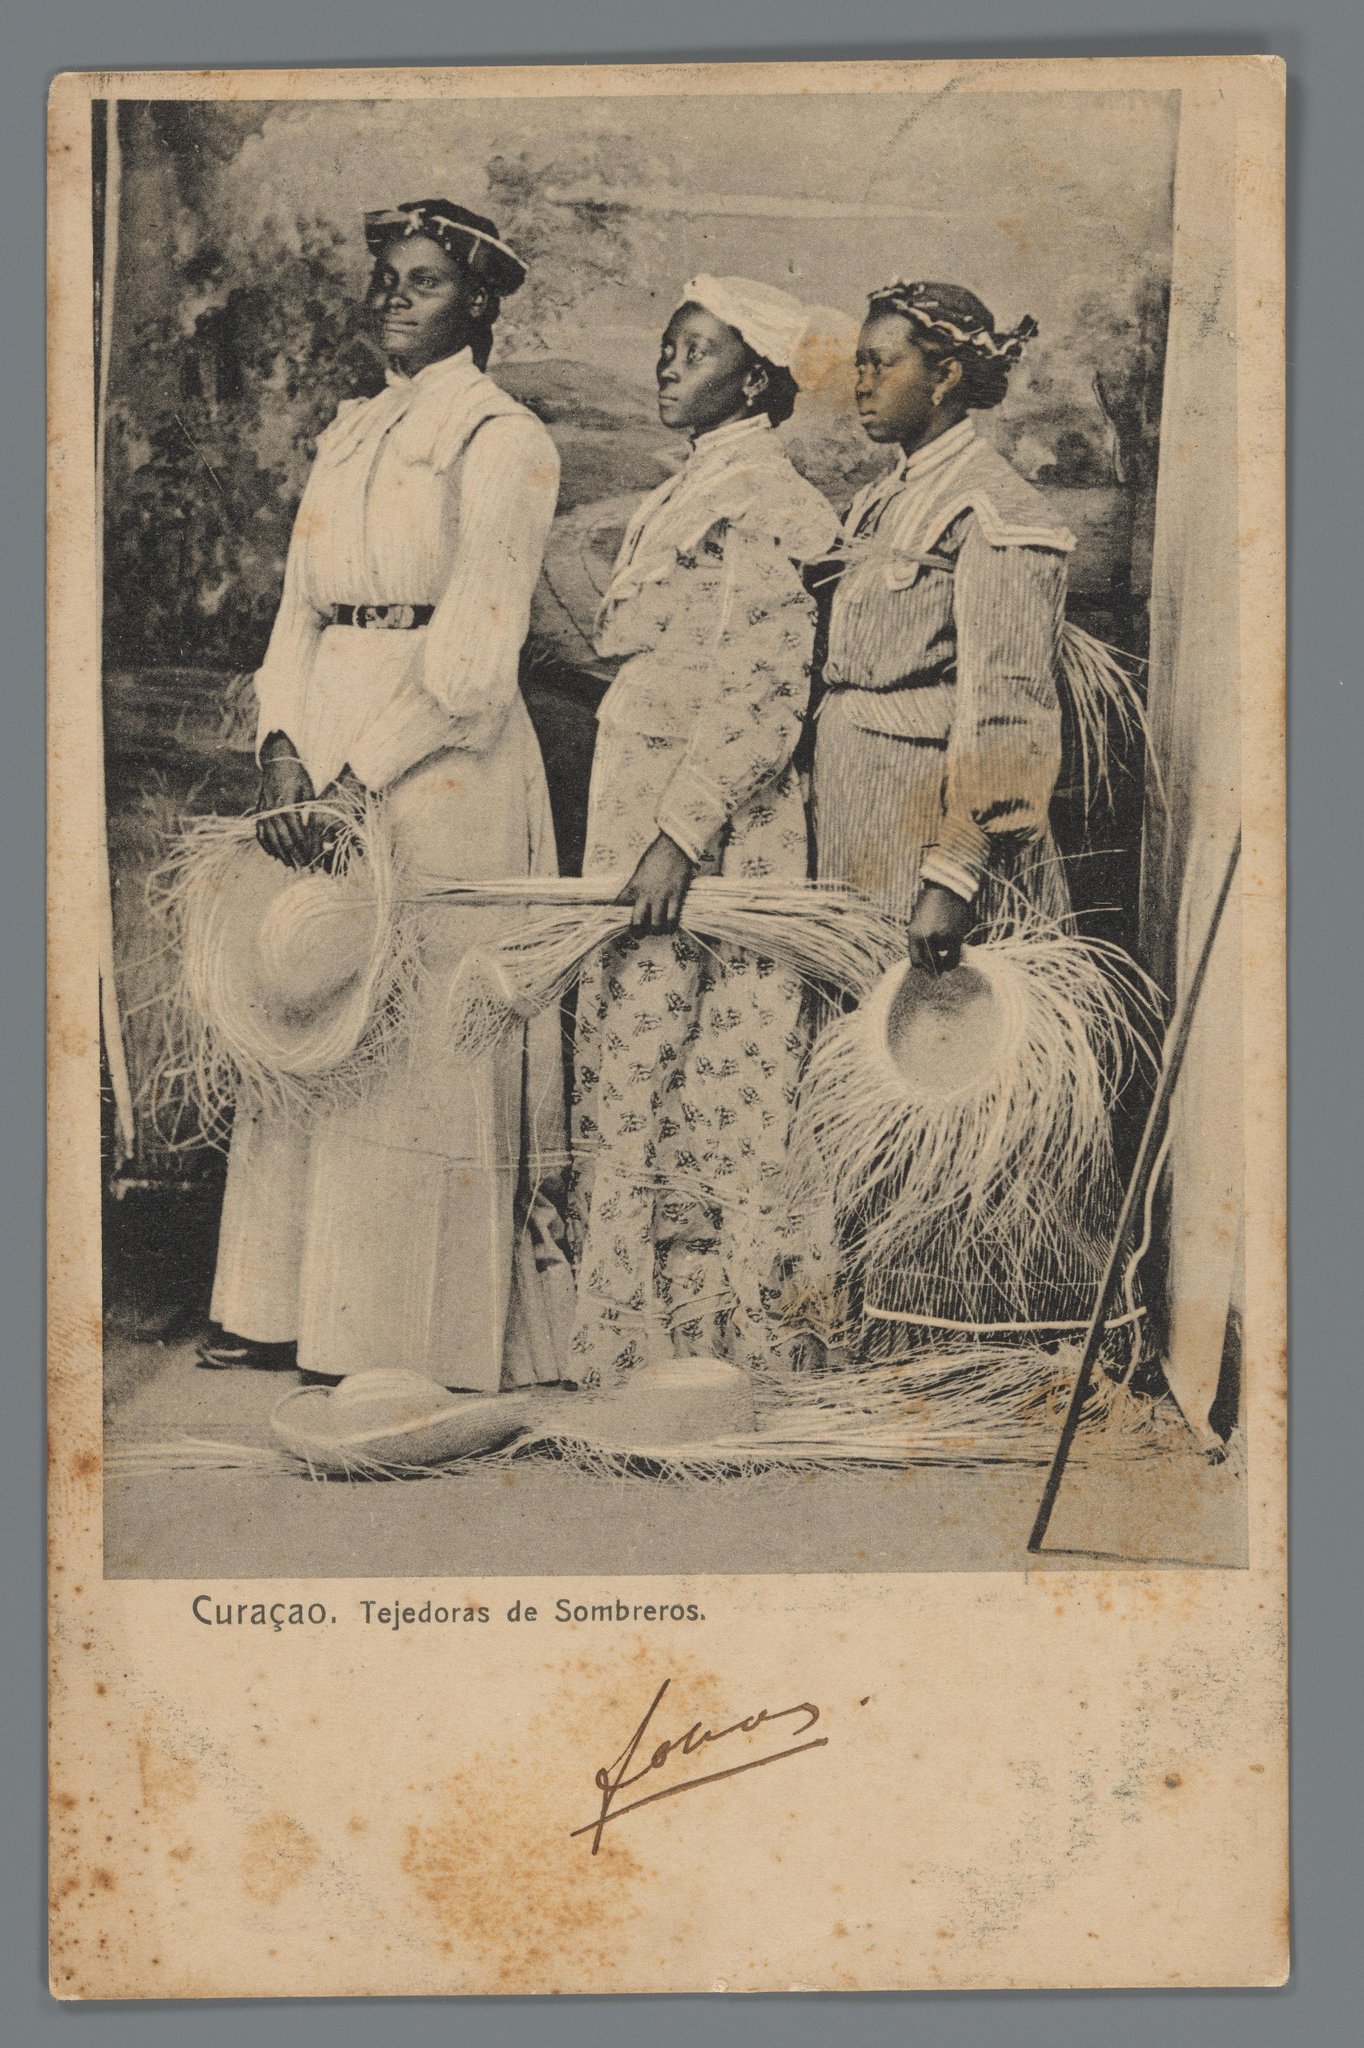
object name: ansichtkaart, prentbriefkaart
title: Curaçao, Tejedoras de Sombreros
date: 1905-1925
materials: cardboard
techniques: photograph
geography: curacao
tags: anonymous historical persons portrayed in a group, in a group-portrait - bb - woman, head-gear: hat